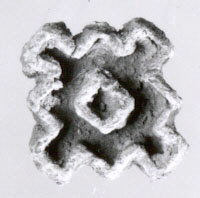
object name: stamp seal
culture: bactria-margiana archaeological complex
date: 2333-1668 BCE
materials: copper alloy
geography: bactria-margiana